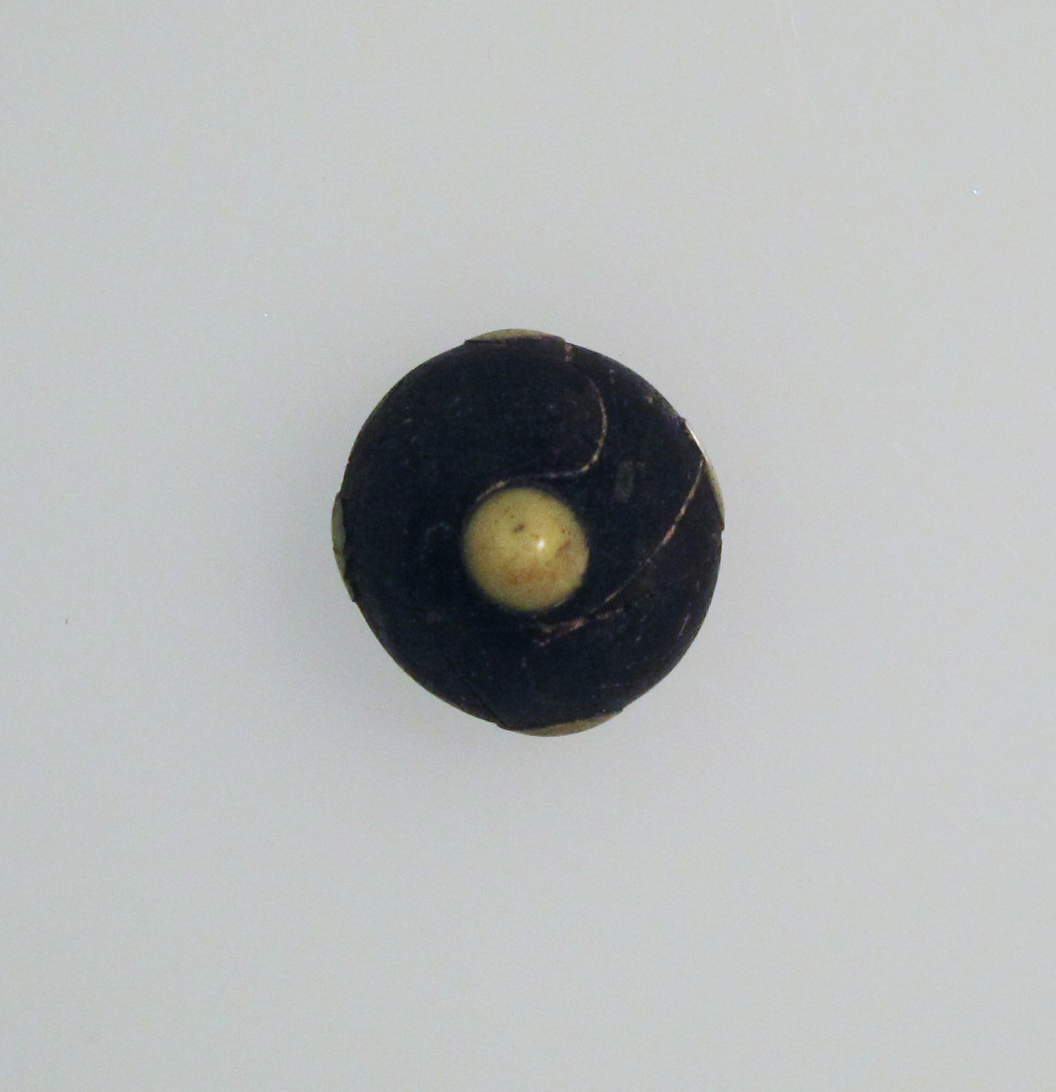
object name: ornament cone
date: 7000 BCE-330 CE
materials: glass